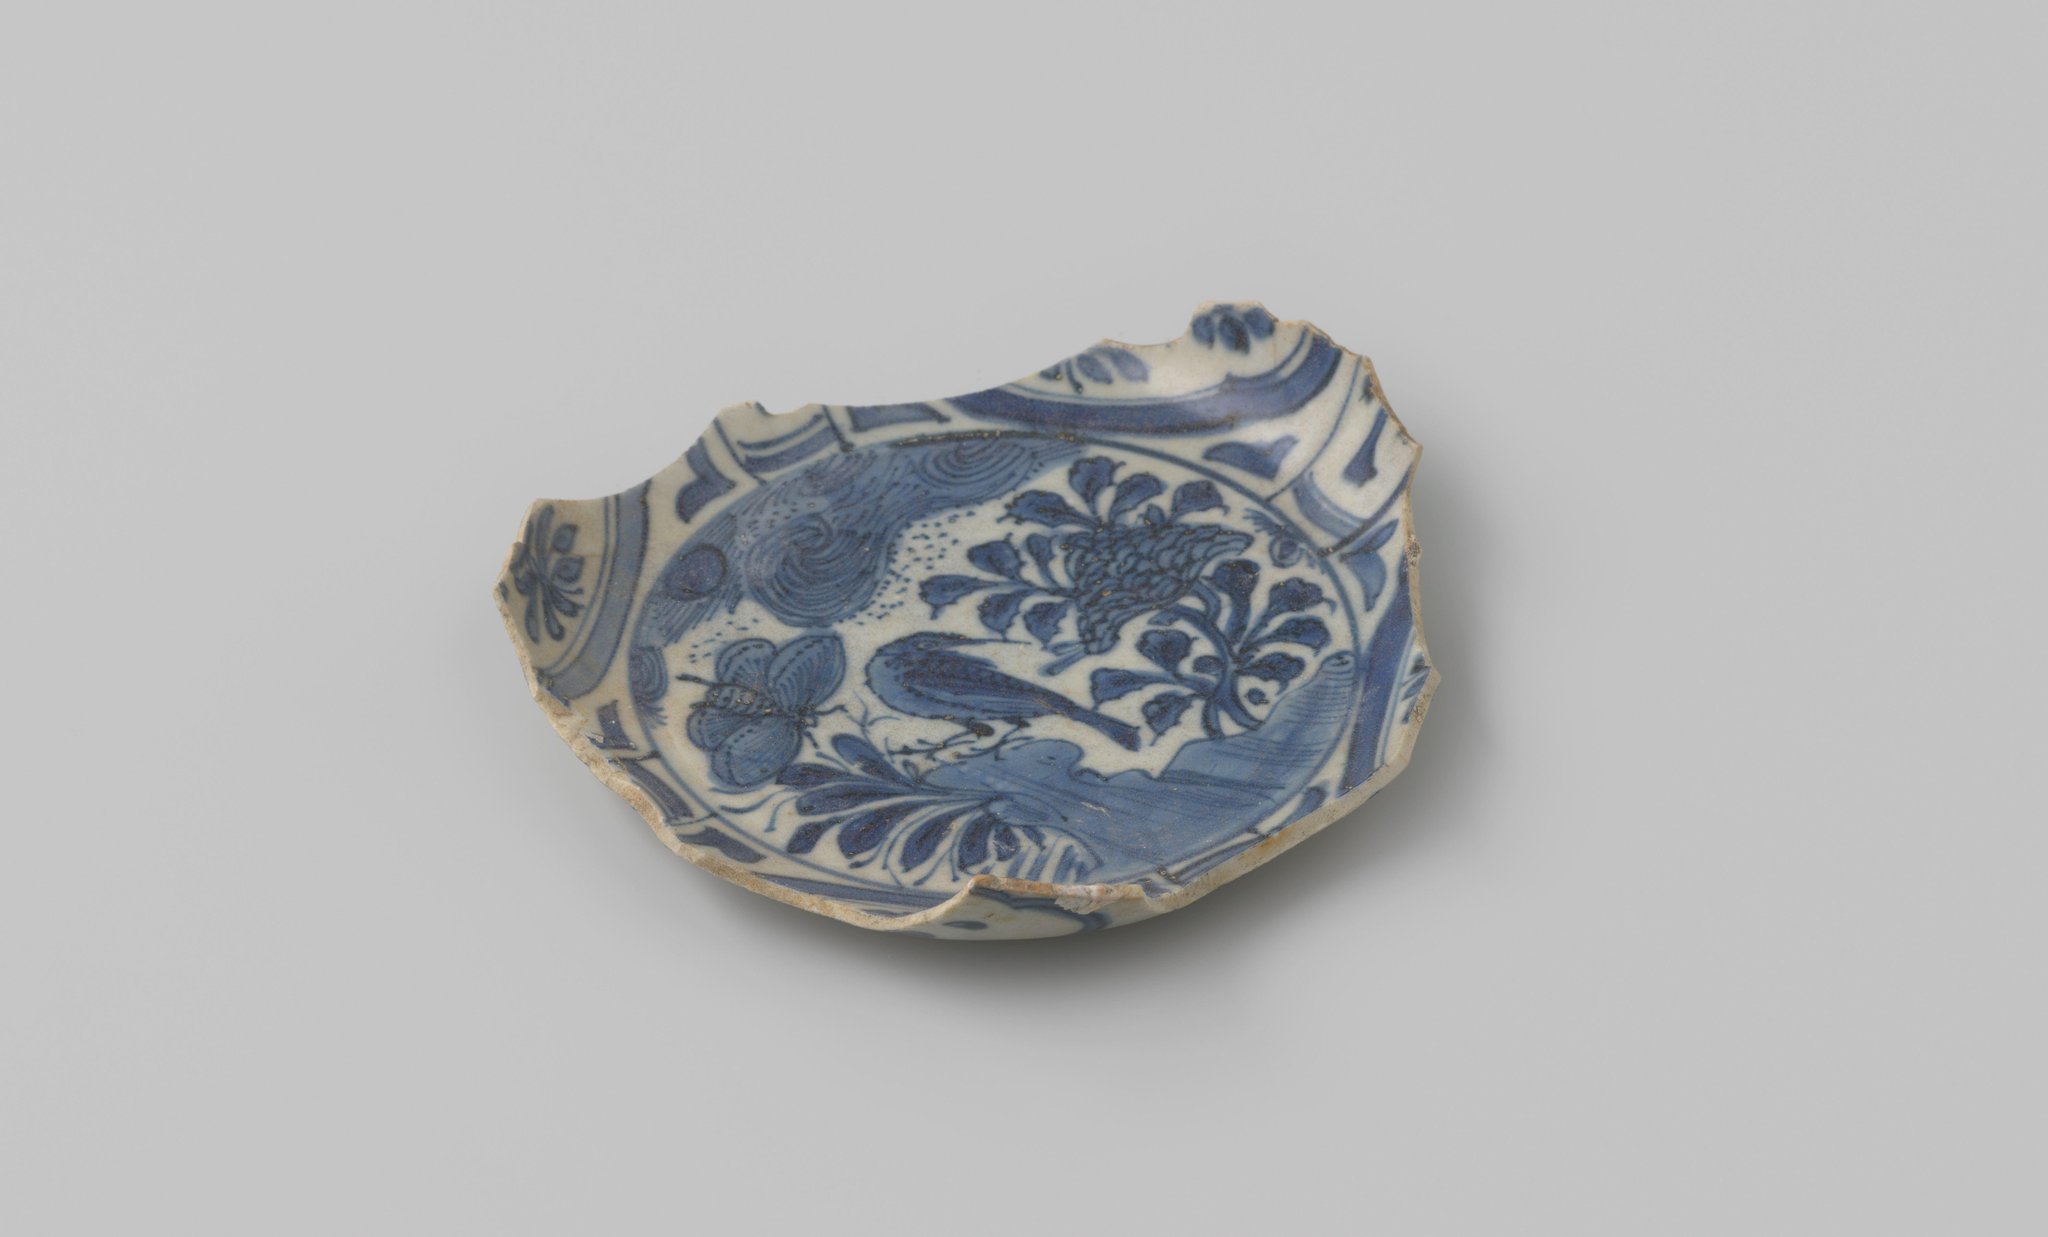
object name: sherd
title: Fragment diep bord uit V.O.C.-schip de 'Witte Leeuw'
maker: Anonymous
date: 1613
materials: bone china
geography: jingdezhen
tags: verenigde oostindische compagnie, sint-helena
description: Fragment diep bord uit V.O.C.-schip de 'Witte Leeuw'.